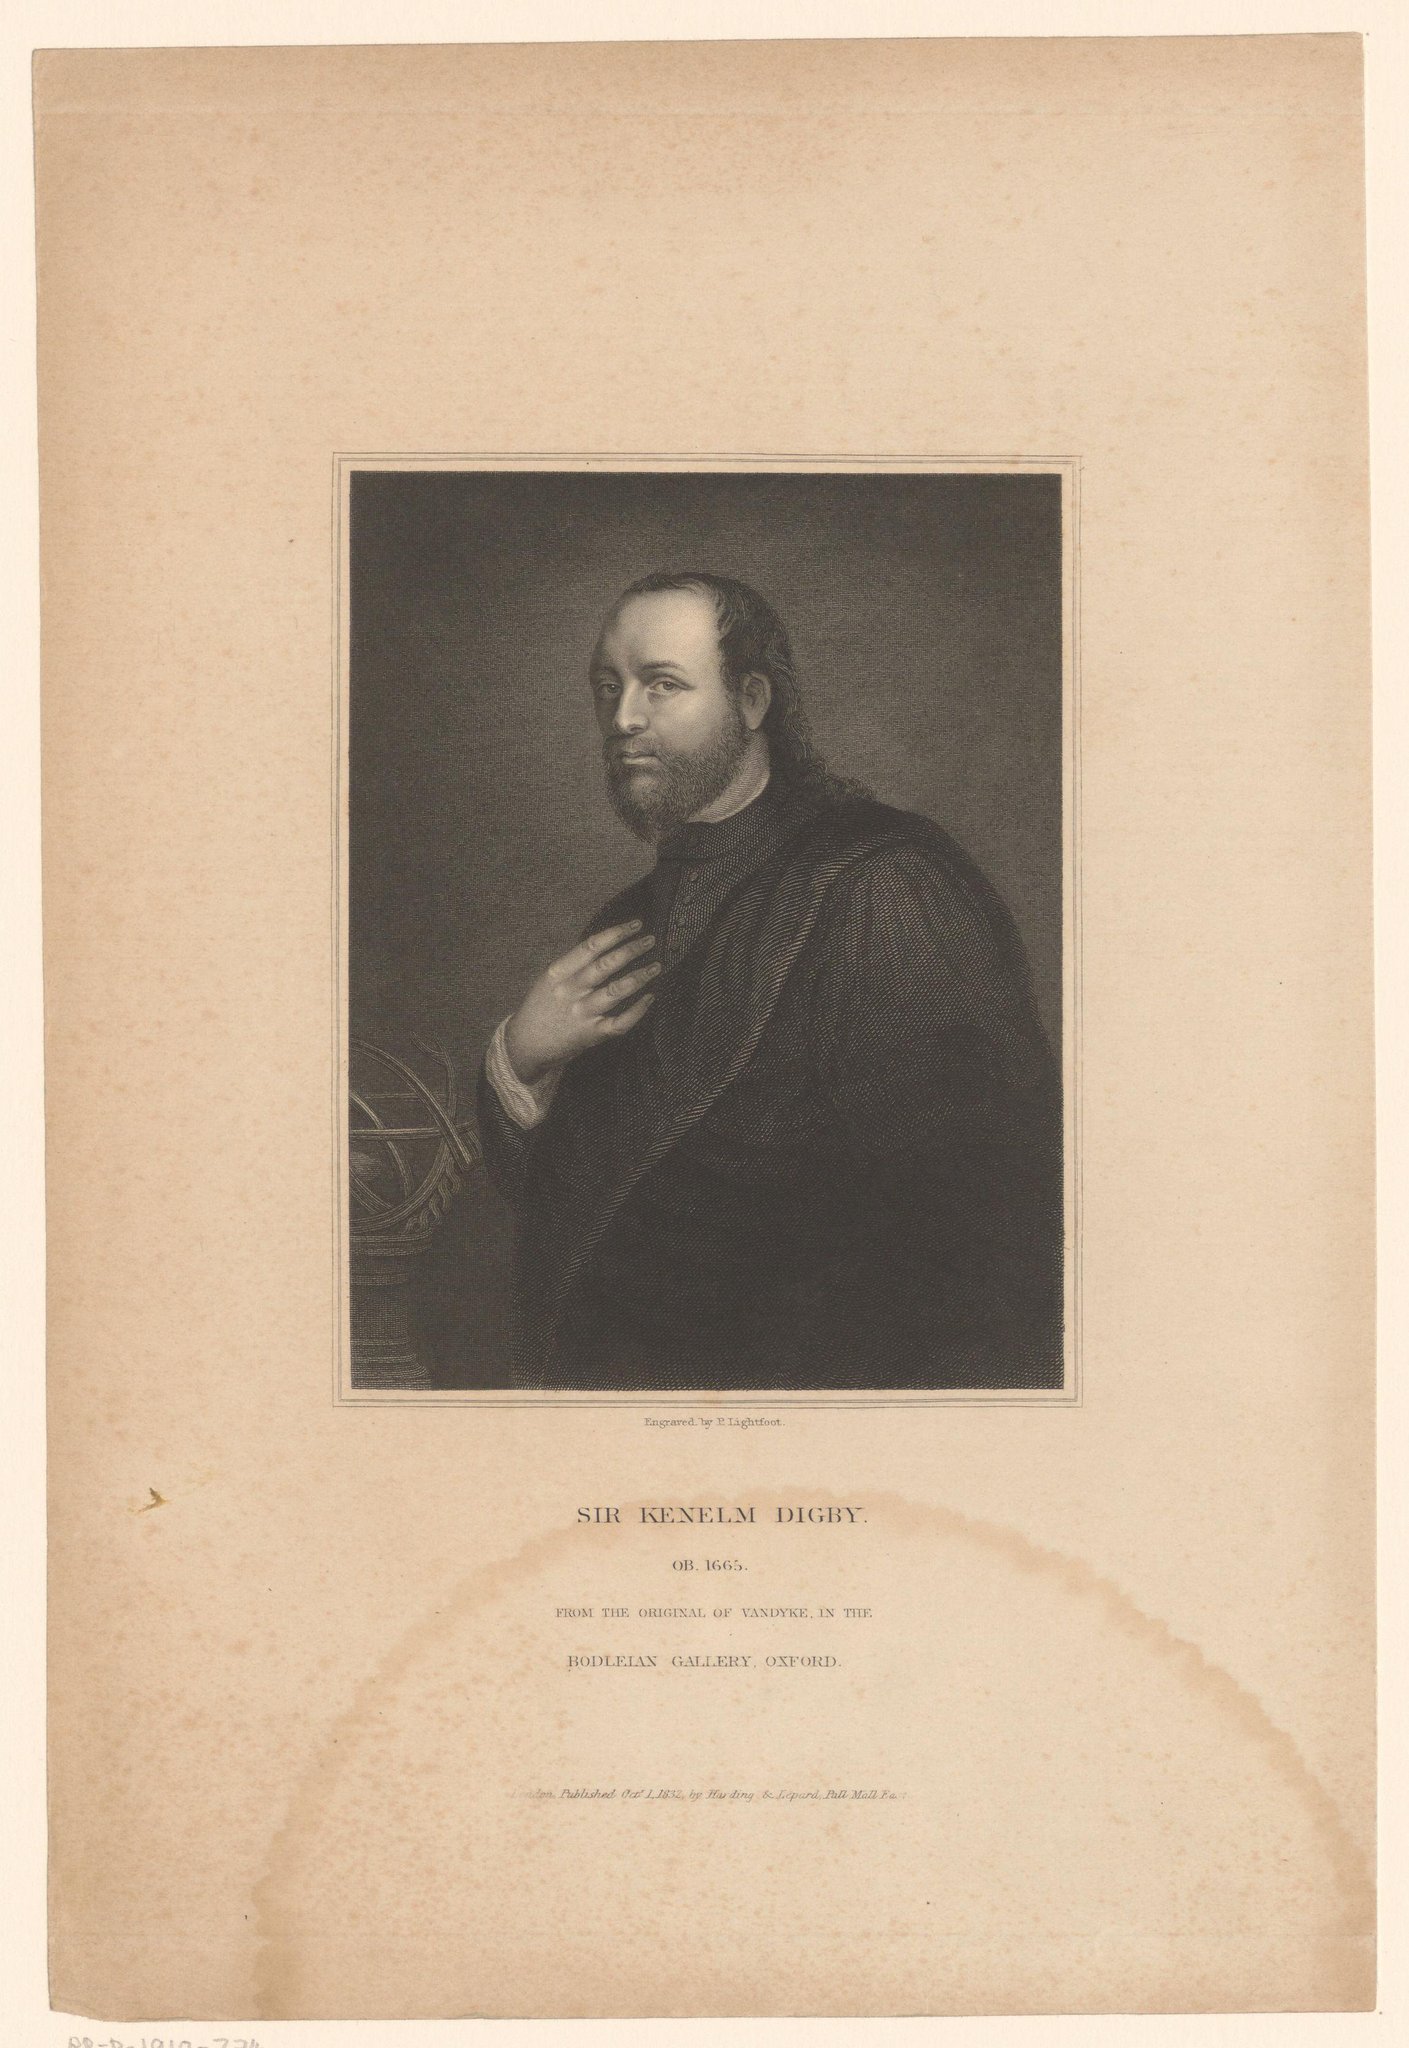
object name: print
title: Portret van Kenelm Digby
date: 1832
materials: paper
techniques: engraving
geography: london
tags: london, physicist, historical persons, diplomacy, diplomat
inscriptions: collector's mark: Lugt 2228